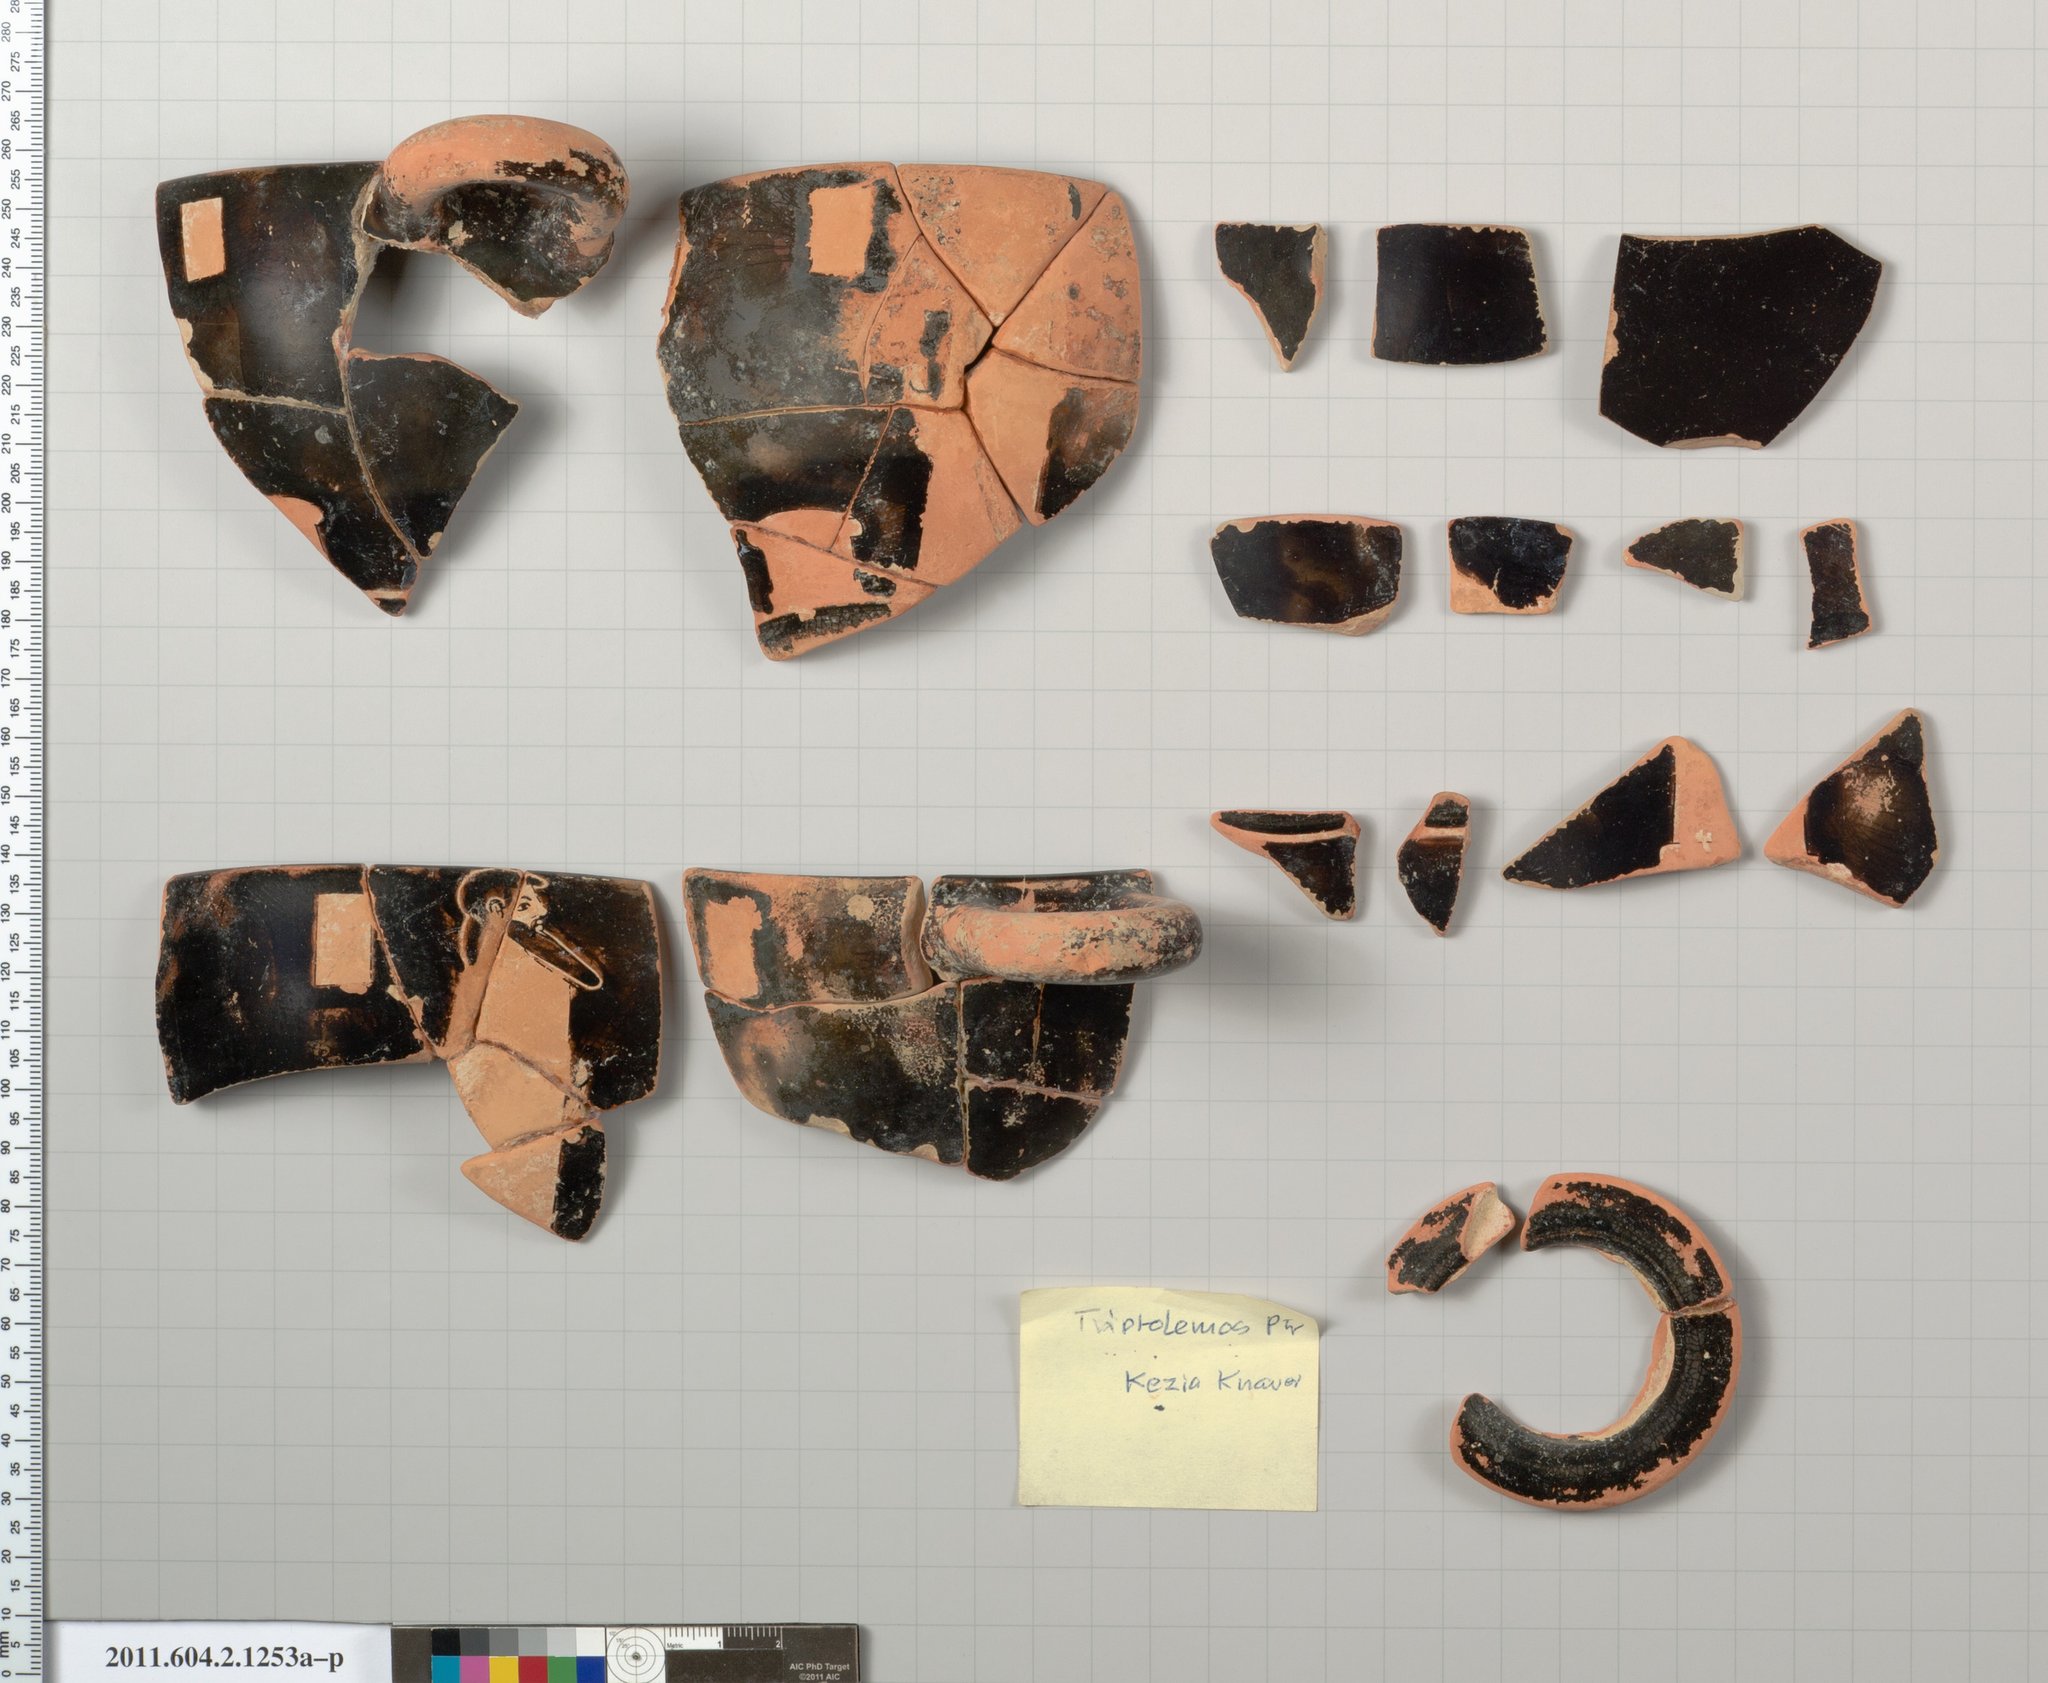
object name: skyphos fragment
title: Terracotta fragments of a skyphos (deep drinking cup)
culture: greek, attic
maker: triptolemos painter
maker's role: artist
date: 490-480 BCE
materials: terracotta